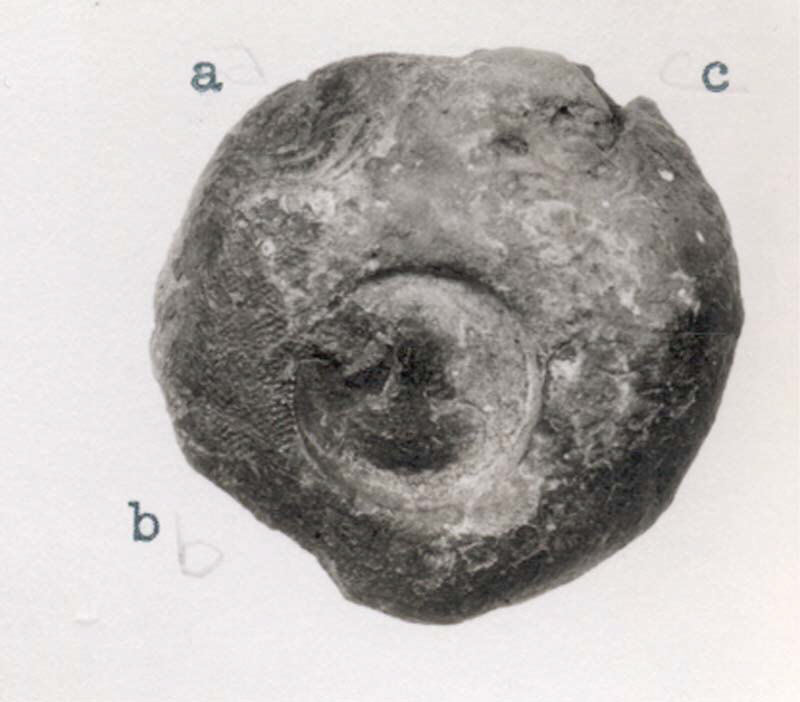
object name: sealing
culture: sasanian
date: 601-700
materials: clay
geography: iran